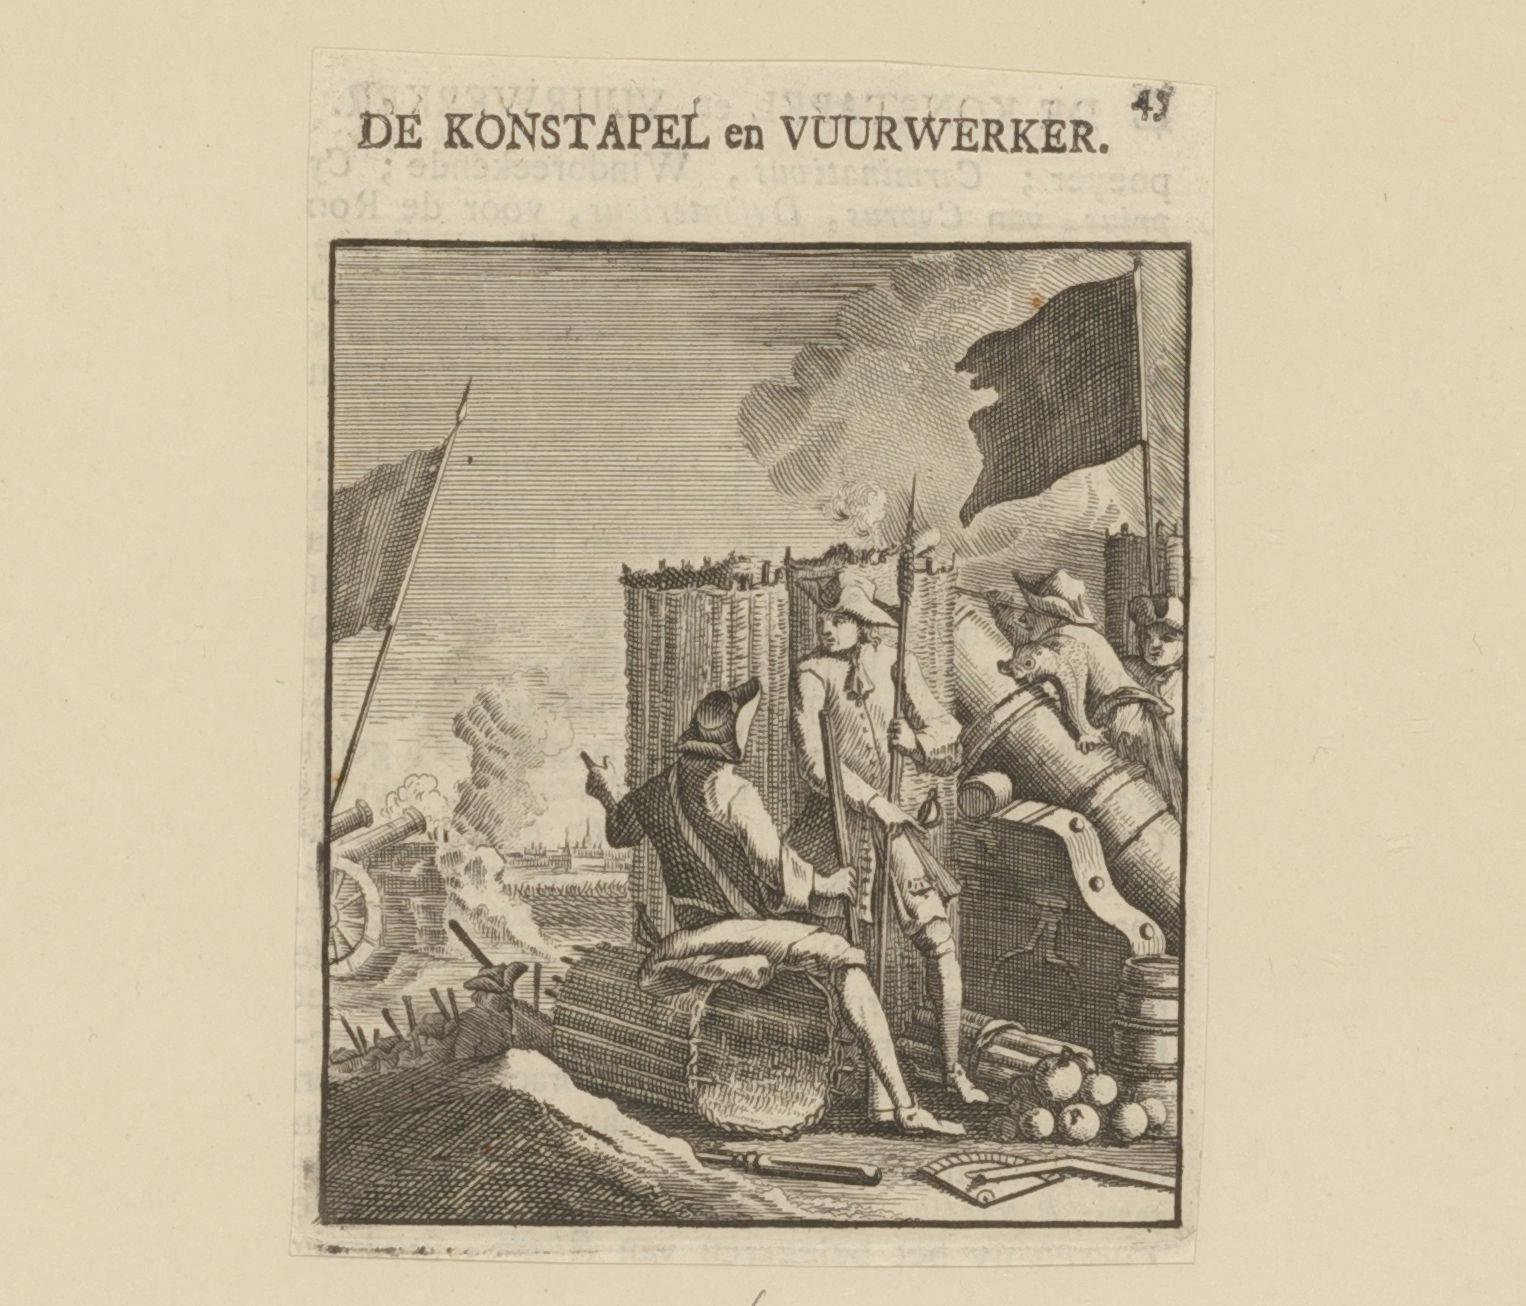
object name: print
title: Afvuren van een kanon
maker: Anonymous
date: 1719-1759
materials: paper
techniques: etching, letterpress printing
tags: military service, firearms: cannon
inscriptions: collector's mark: Lugt 1641, stamp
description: Prent met andere letterzetting gebruikt in: St. Clara, Abraham van. Iets voor allen. [Vertaald door] J. le Long. Amsterdam: Janssoons van Waesberge, 1719, dl. 2. En in: St. Clara, Abraham van. Iets voor allen. [Vertaald door] J. le Long. Amsterdam: Jan Roman de Jonge, 1741, dl. 2. En in: St. Clara, Abraham van. Iets voor allen. [Vertaald door] J. le Long. Amsterdam: Jan Roman, 1759, dl. 2. Huidige prent uit een andere editie. Naar een prent van: Jan Luyken.